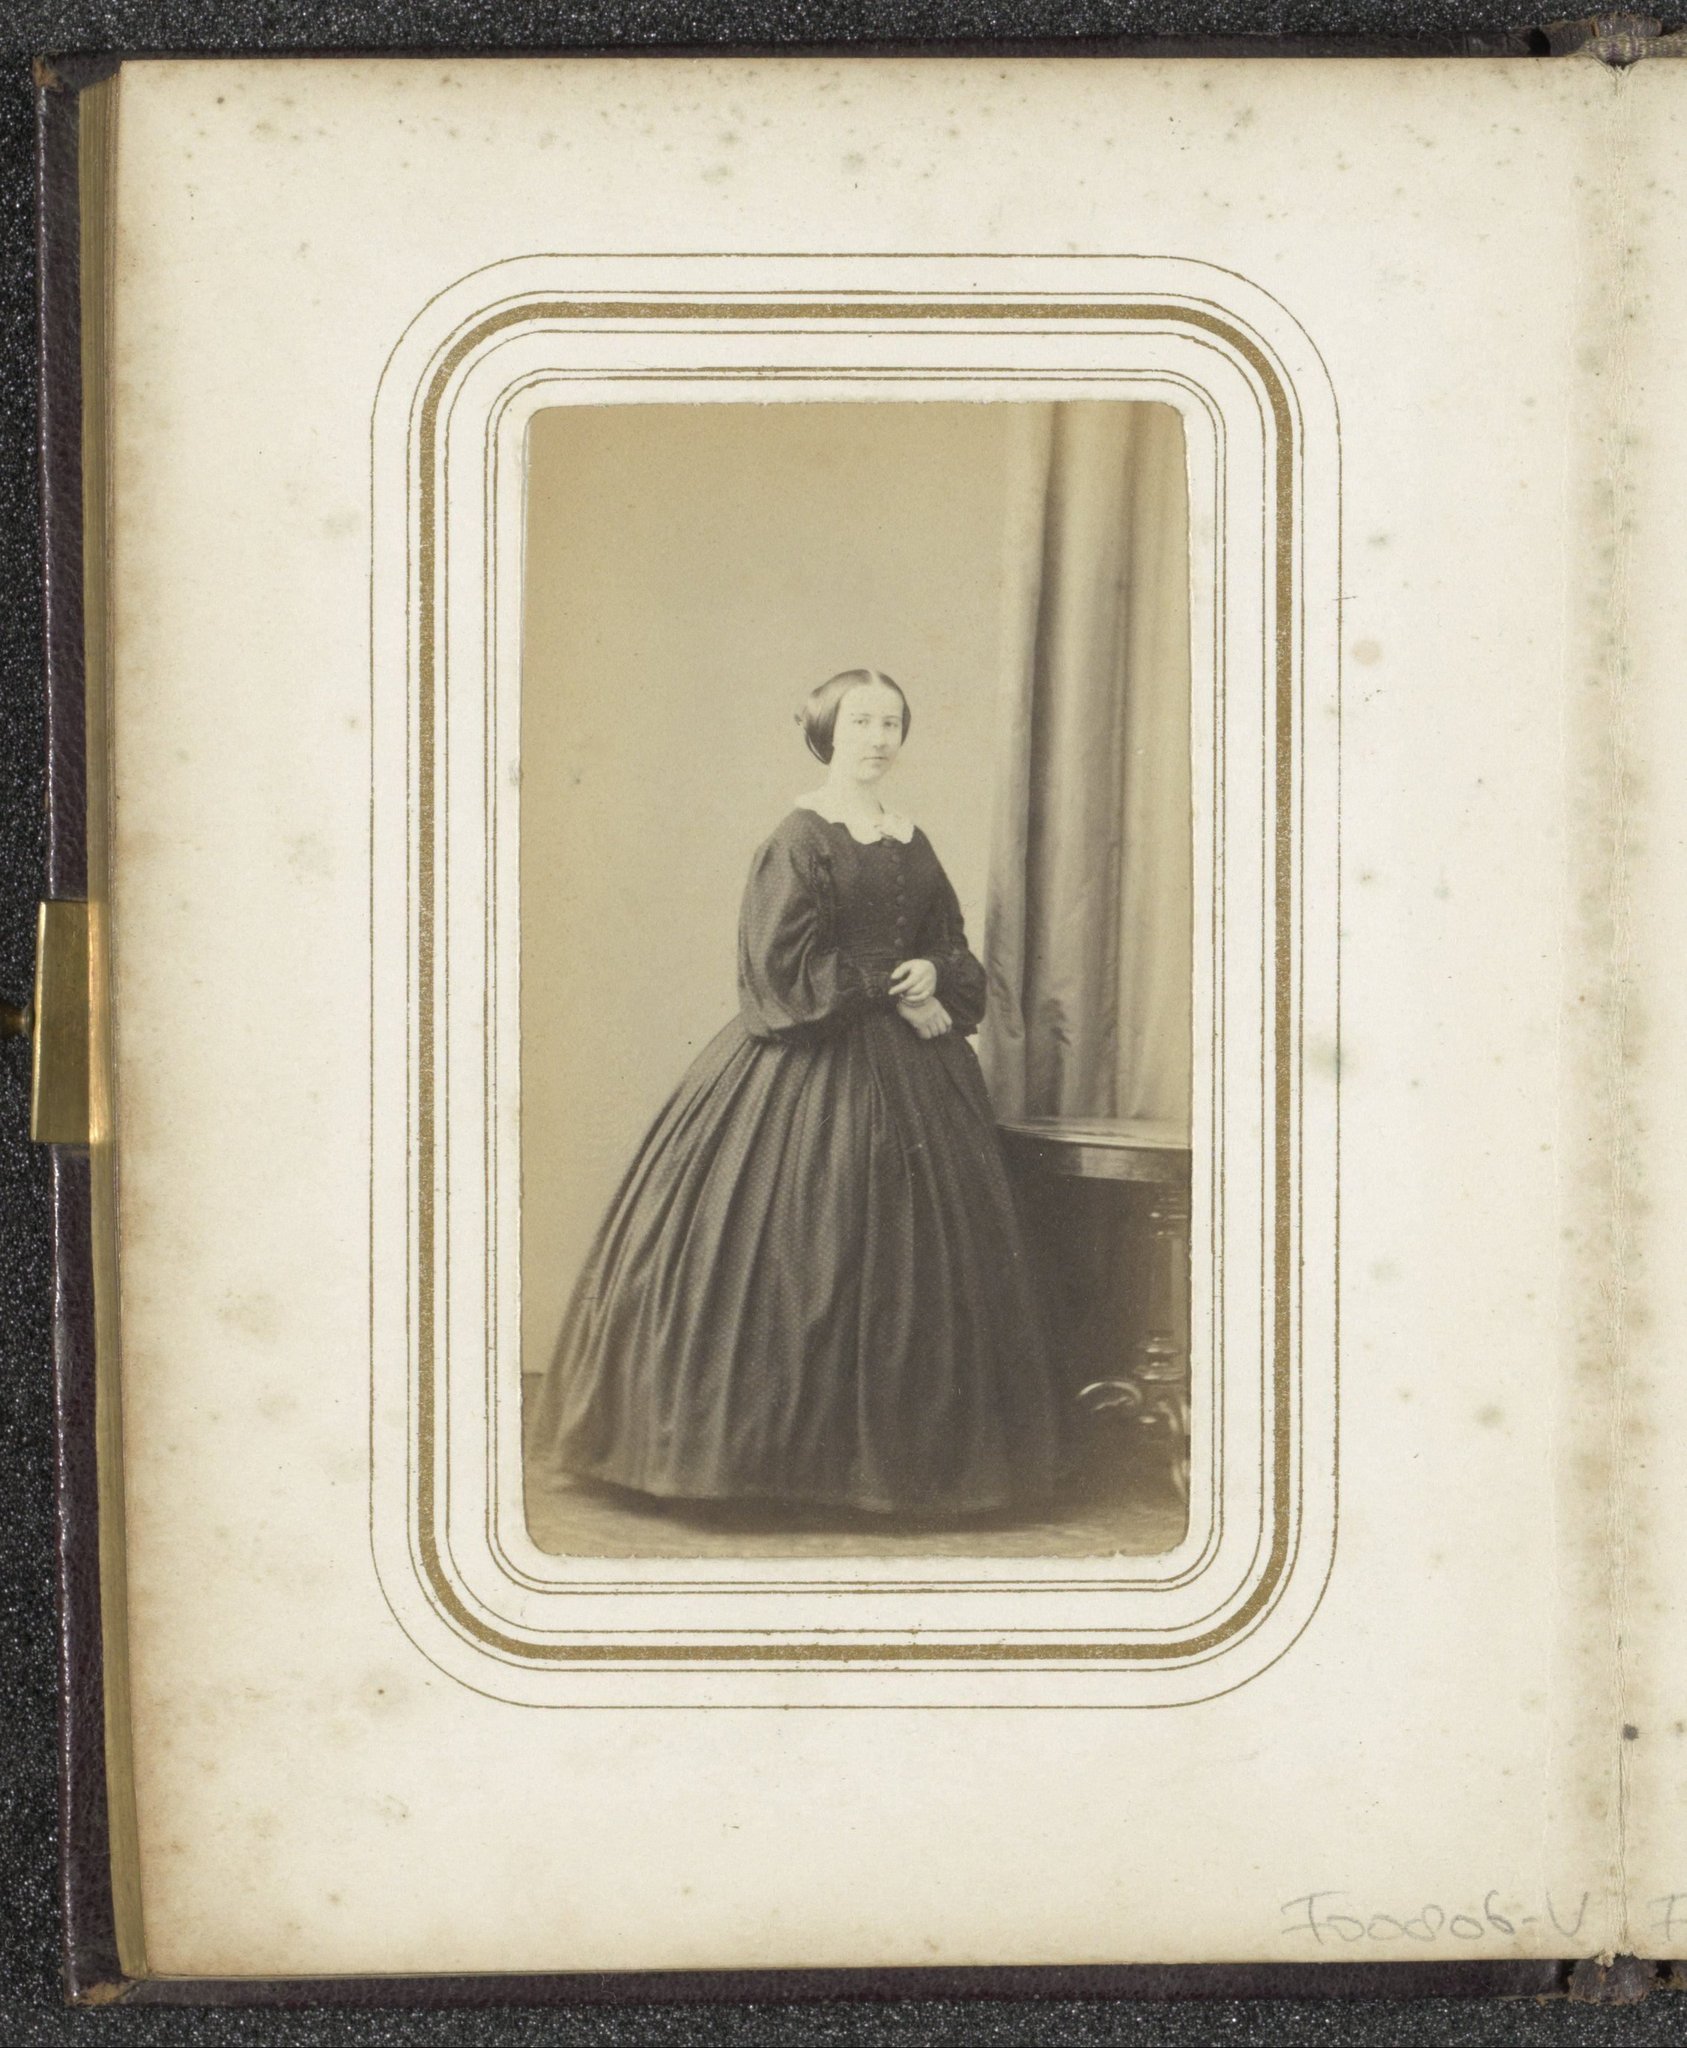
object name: carte de visite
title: Portret van een staande vrouw bij een tafel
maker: jules géruzet (fotograaf)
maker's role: fotograaf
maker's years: 1817-1874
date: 1874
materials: cardboard, paper, photographic support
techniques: albumen print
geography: brussels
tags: studio requisites ~ photographer, historical persons, styles of hairdress - aa - ~ women, neck-gear ~ clothing, dress, gown, brussels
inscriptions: address: ‘27bis, Rue de l'Ecuyer, Bruxelles’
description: Onderdeel van Fotoalbum met 36 cartes-de-visite van Nederlandse personen.